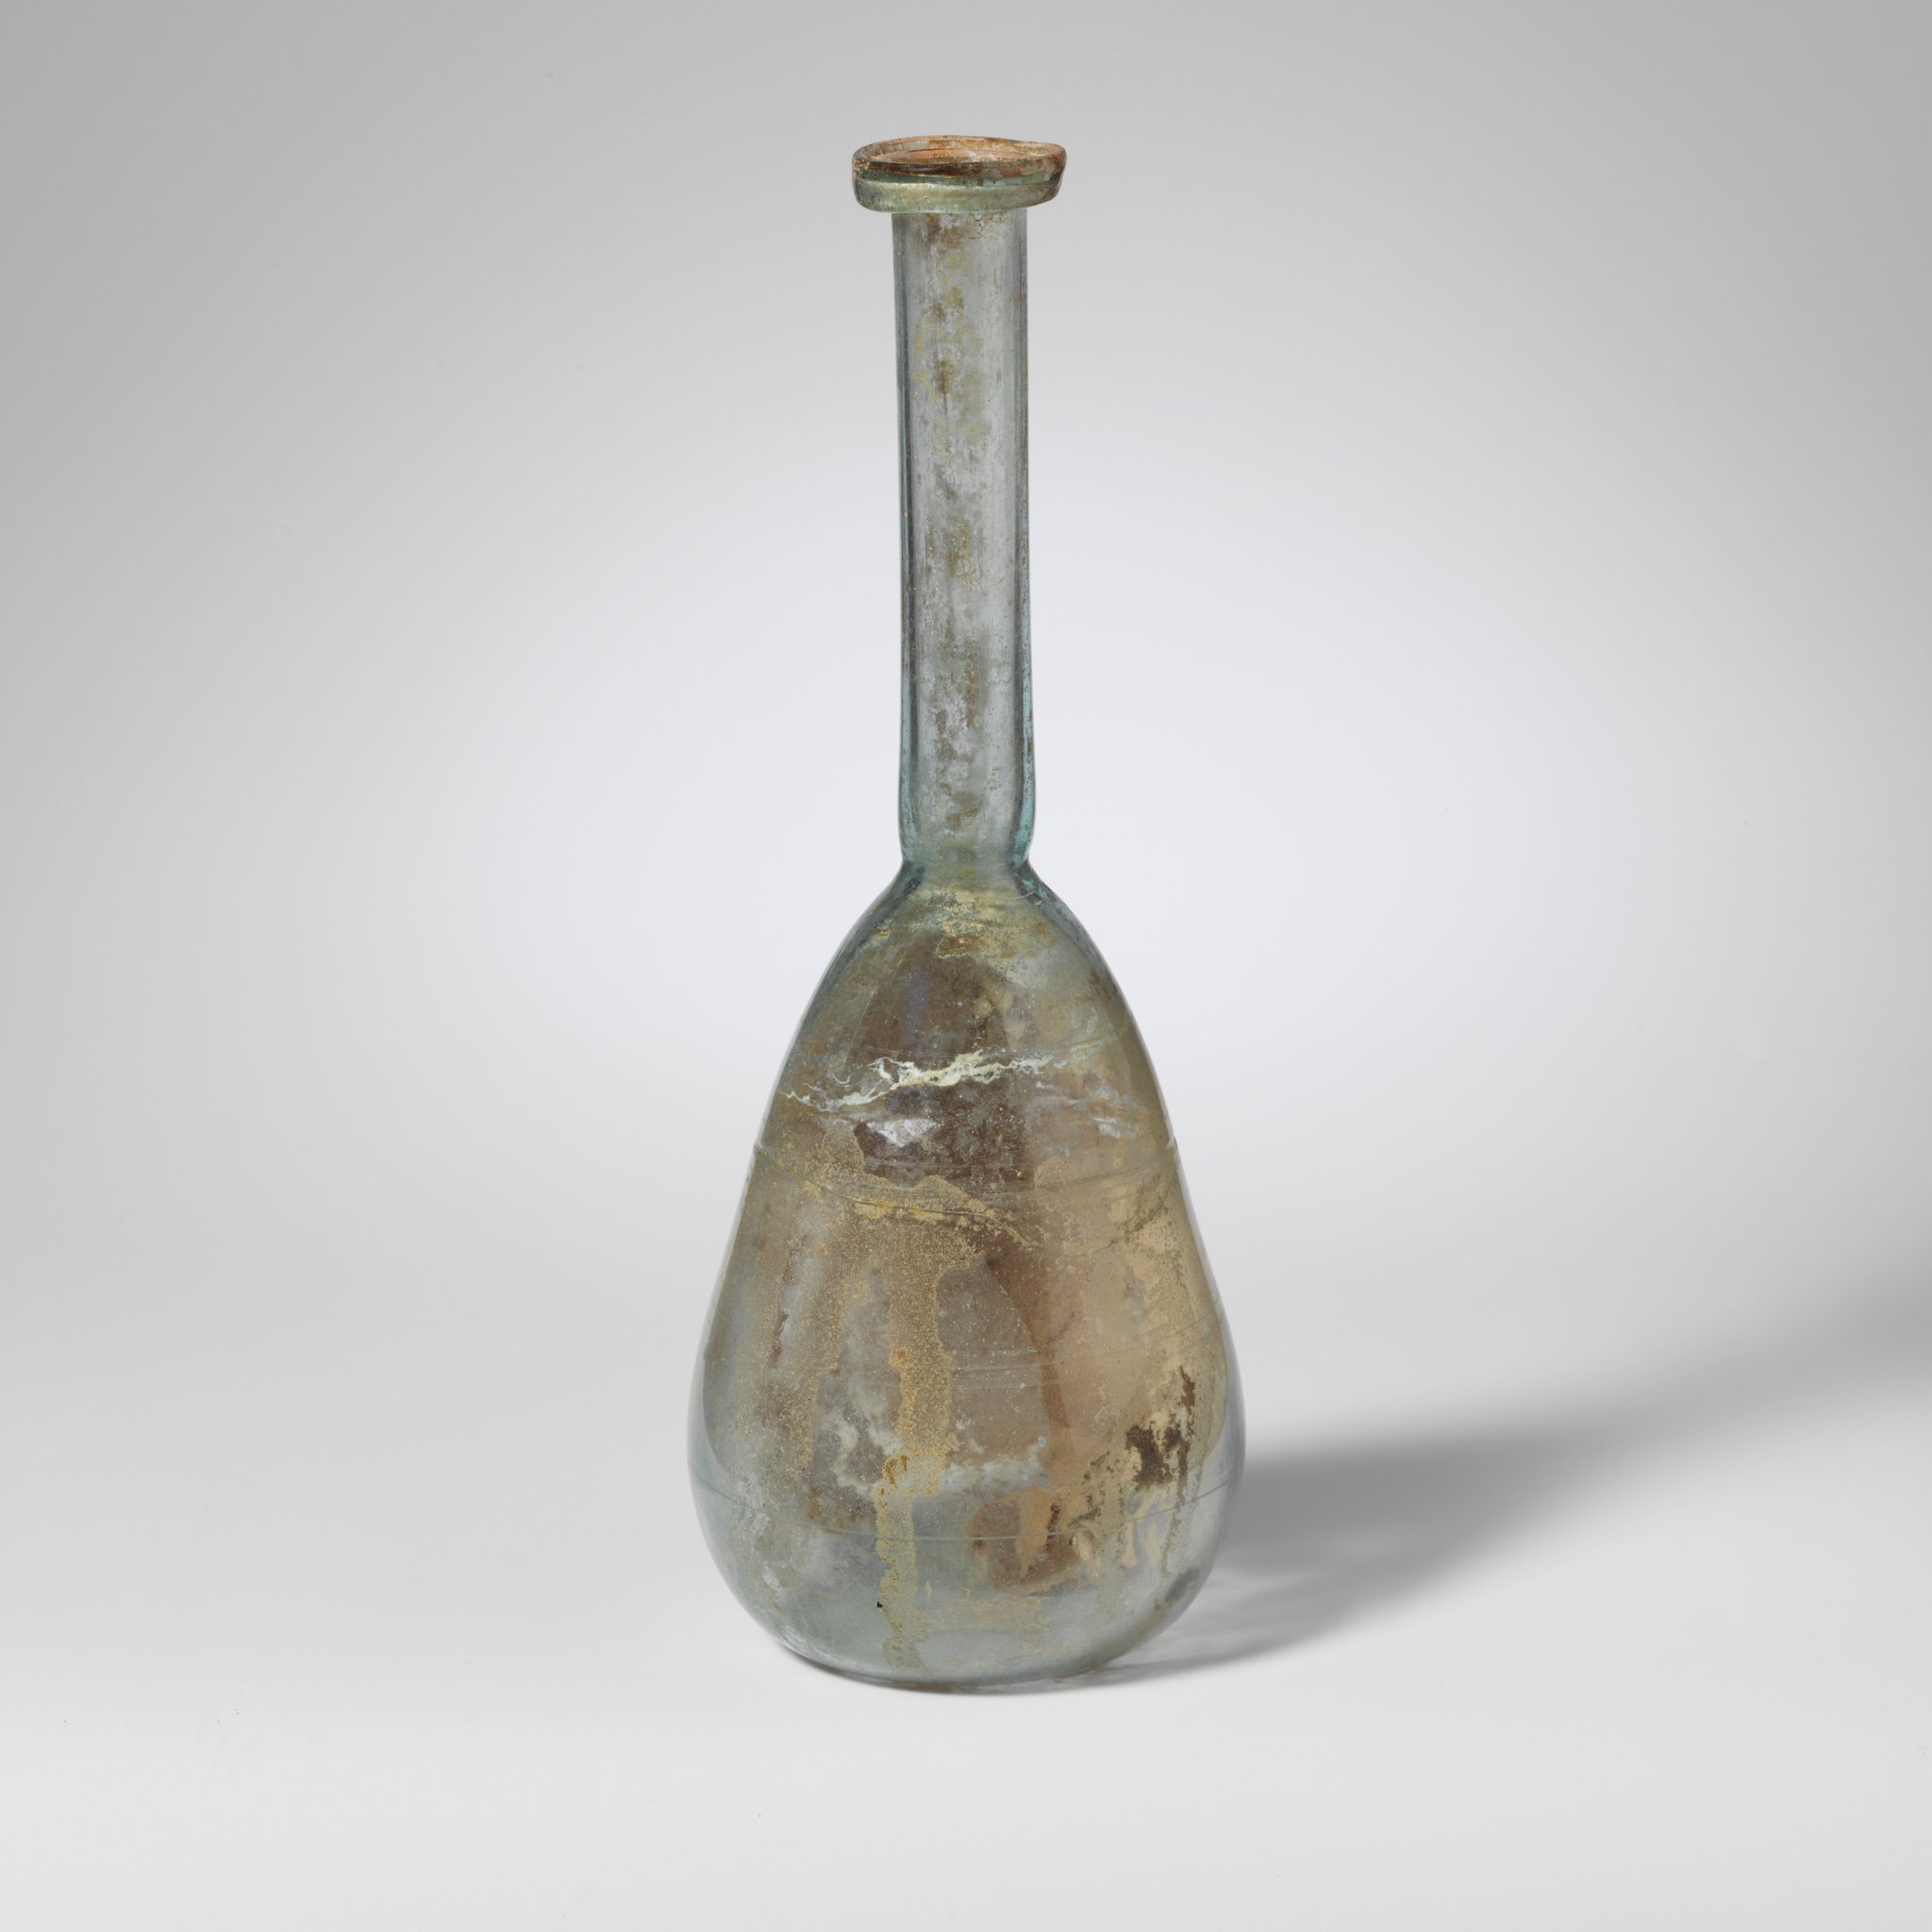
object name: bottle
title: Glass bottle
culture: roman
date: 1-133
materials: glass